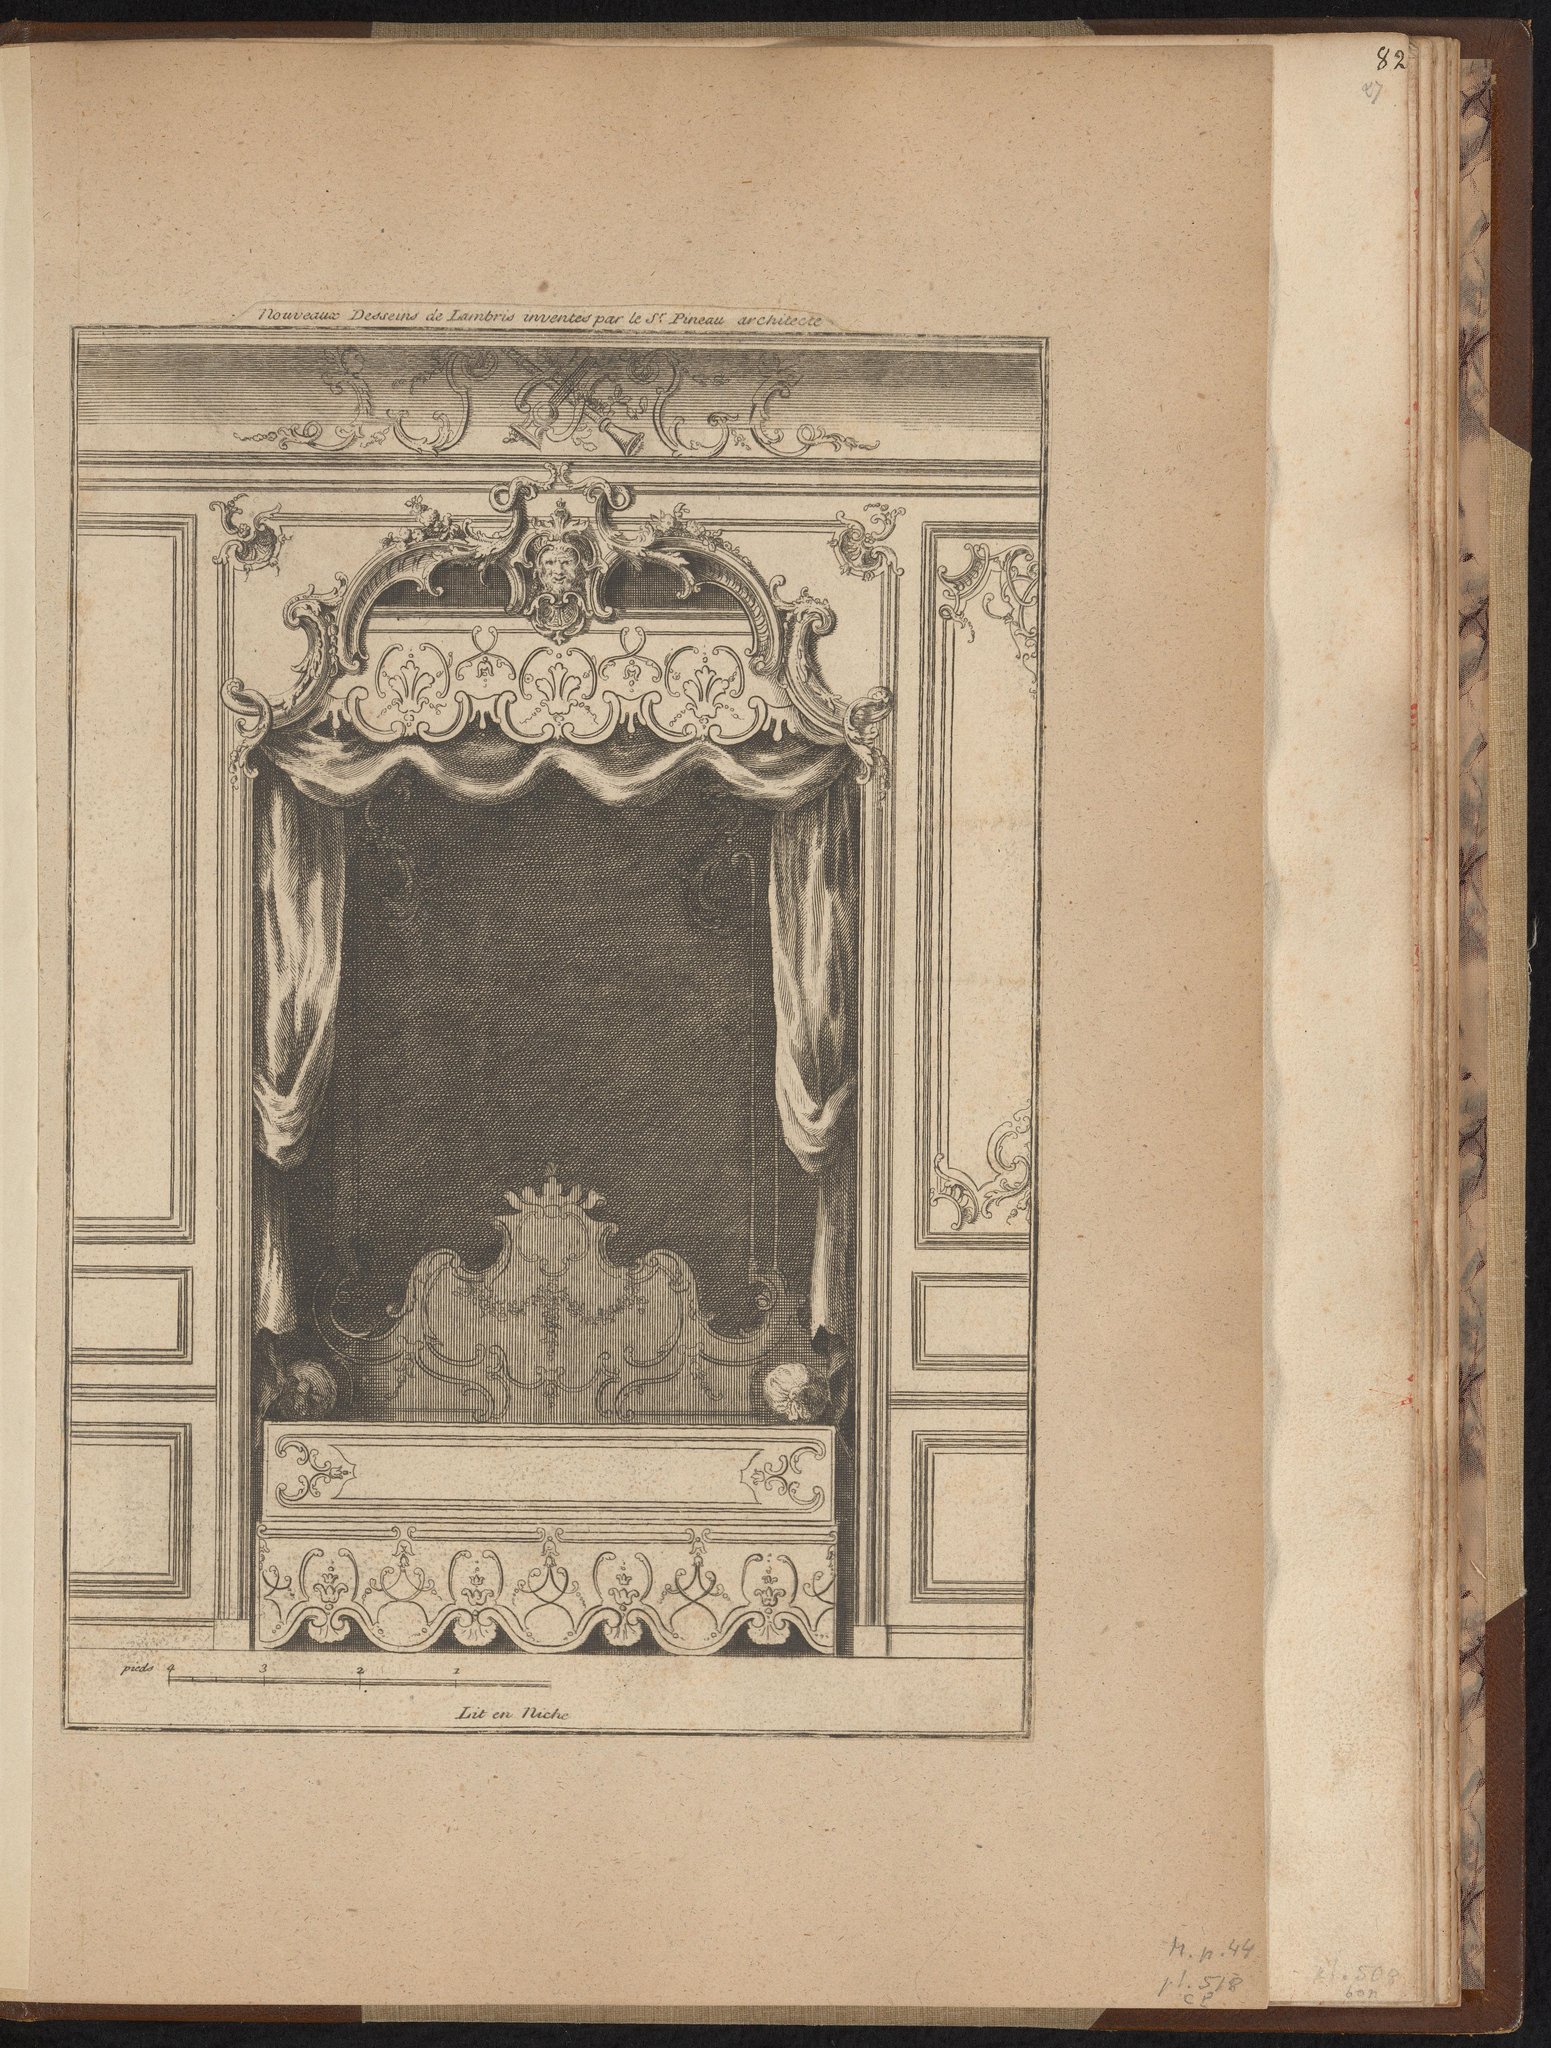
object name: album leaf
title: Nouveaux desseins de lambris inventés par le Sr. Pineau architecte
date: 1725-1750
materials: paper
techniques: etching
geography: paris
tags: ornaments ~ art, bed, bedroom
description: Deze prent maakt deel uit van een album.